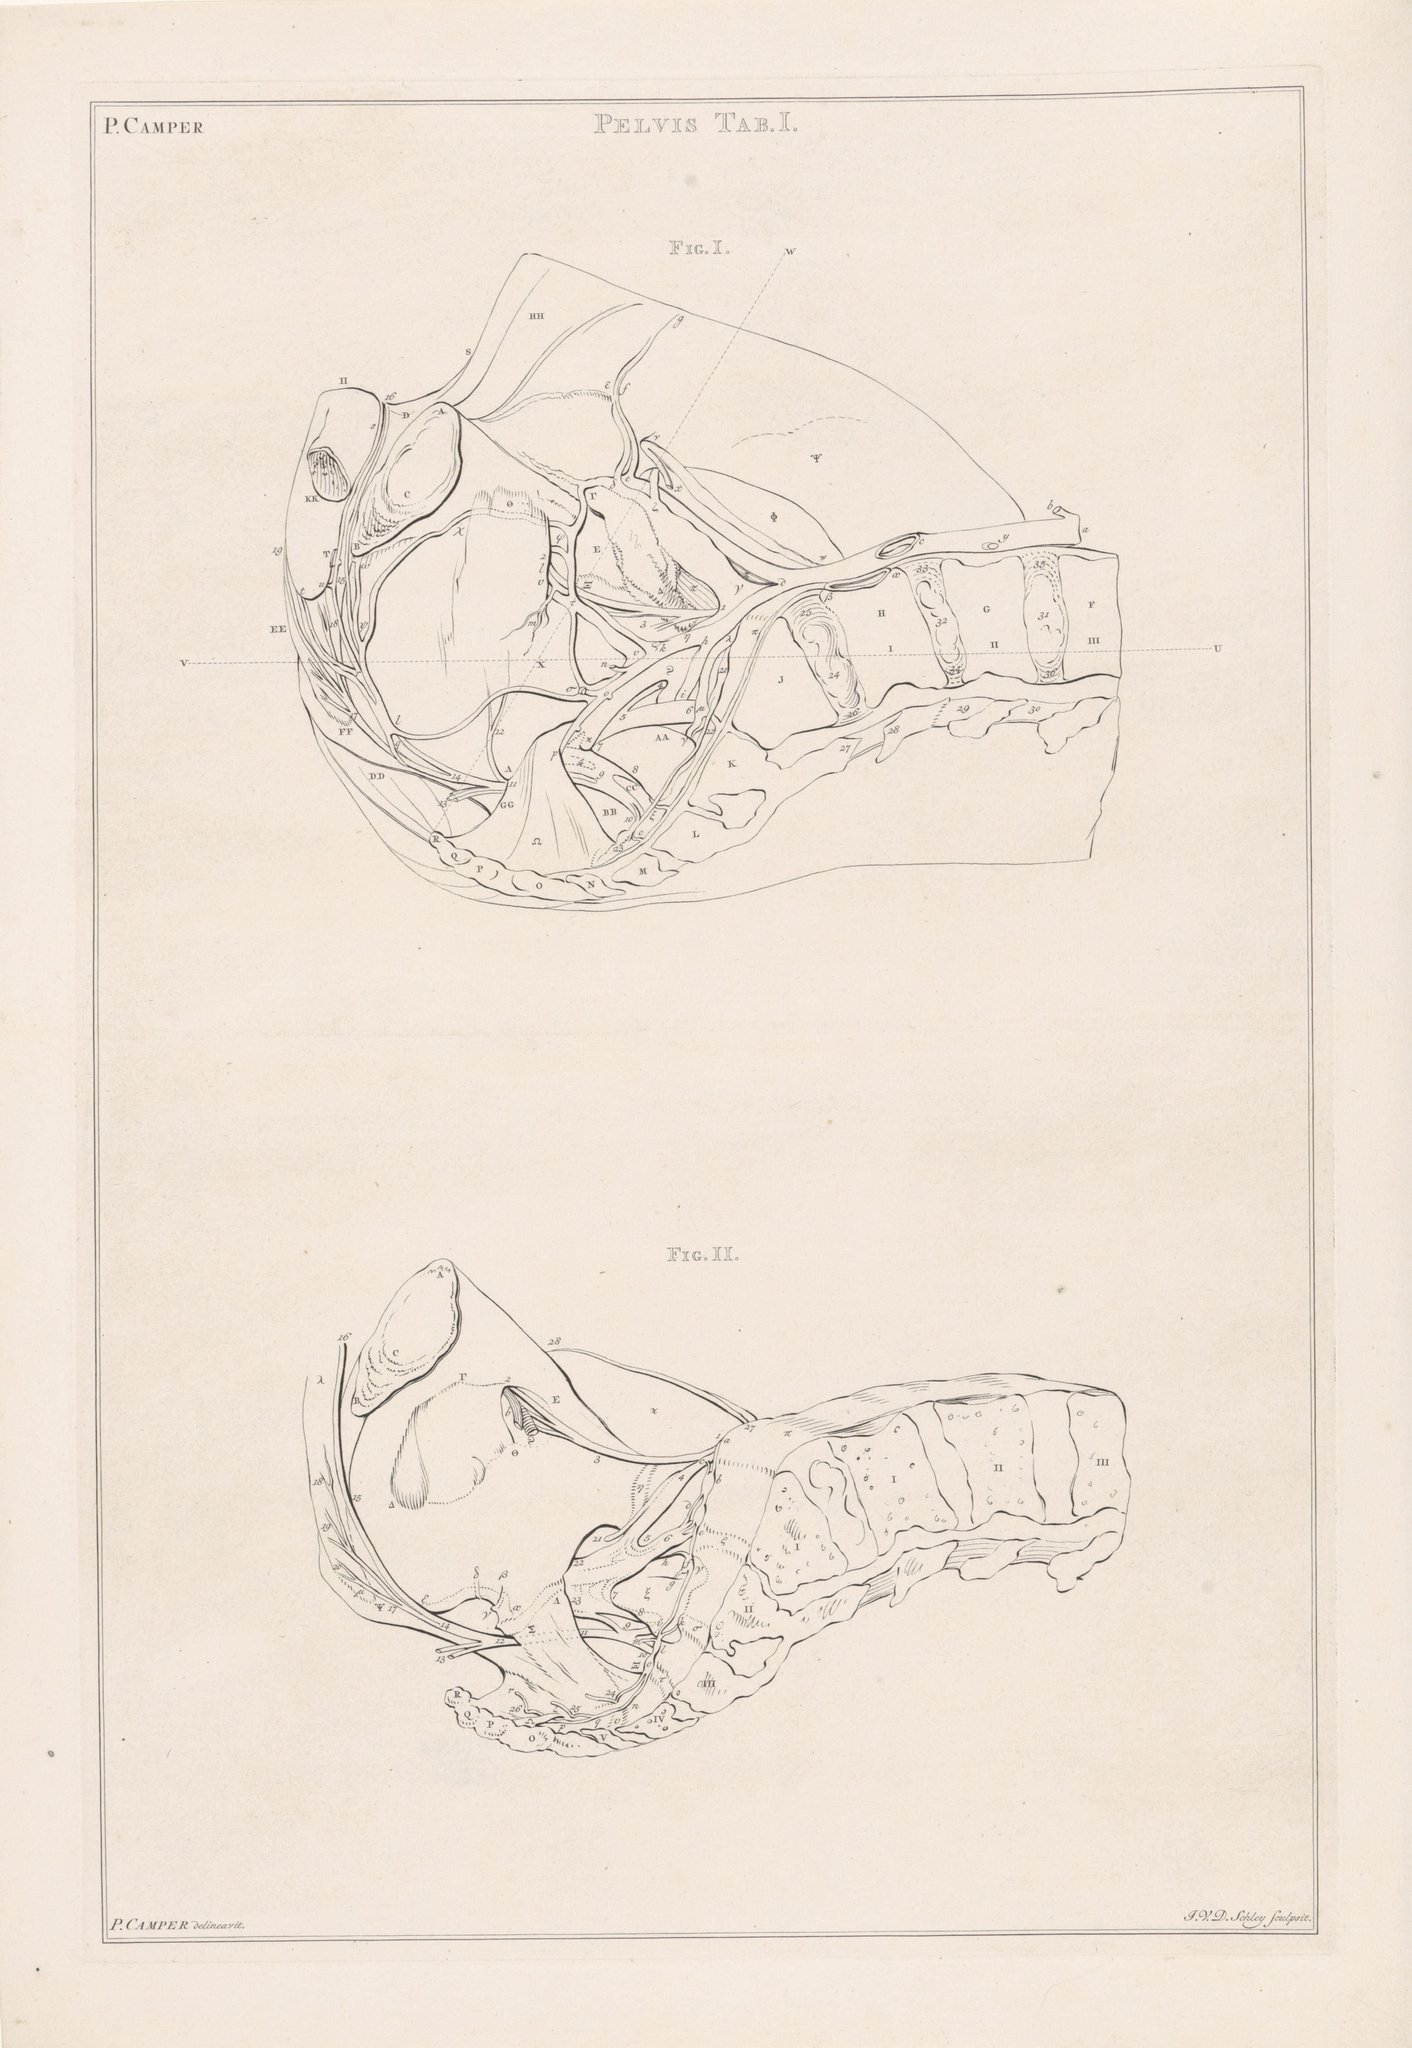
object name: print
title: Pelvis Tab. I.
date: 1762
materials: paper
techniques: engraving, etching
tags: parts of the human body (skeleton excepted), pelvis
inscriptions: collector's mark: Lugt 2228